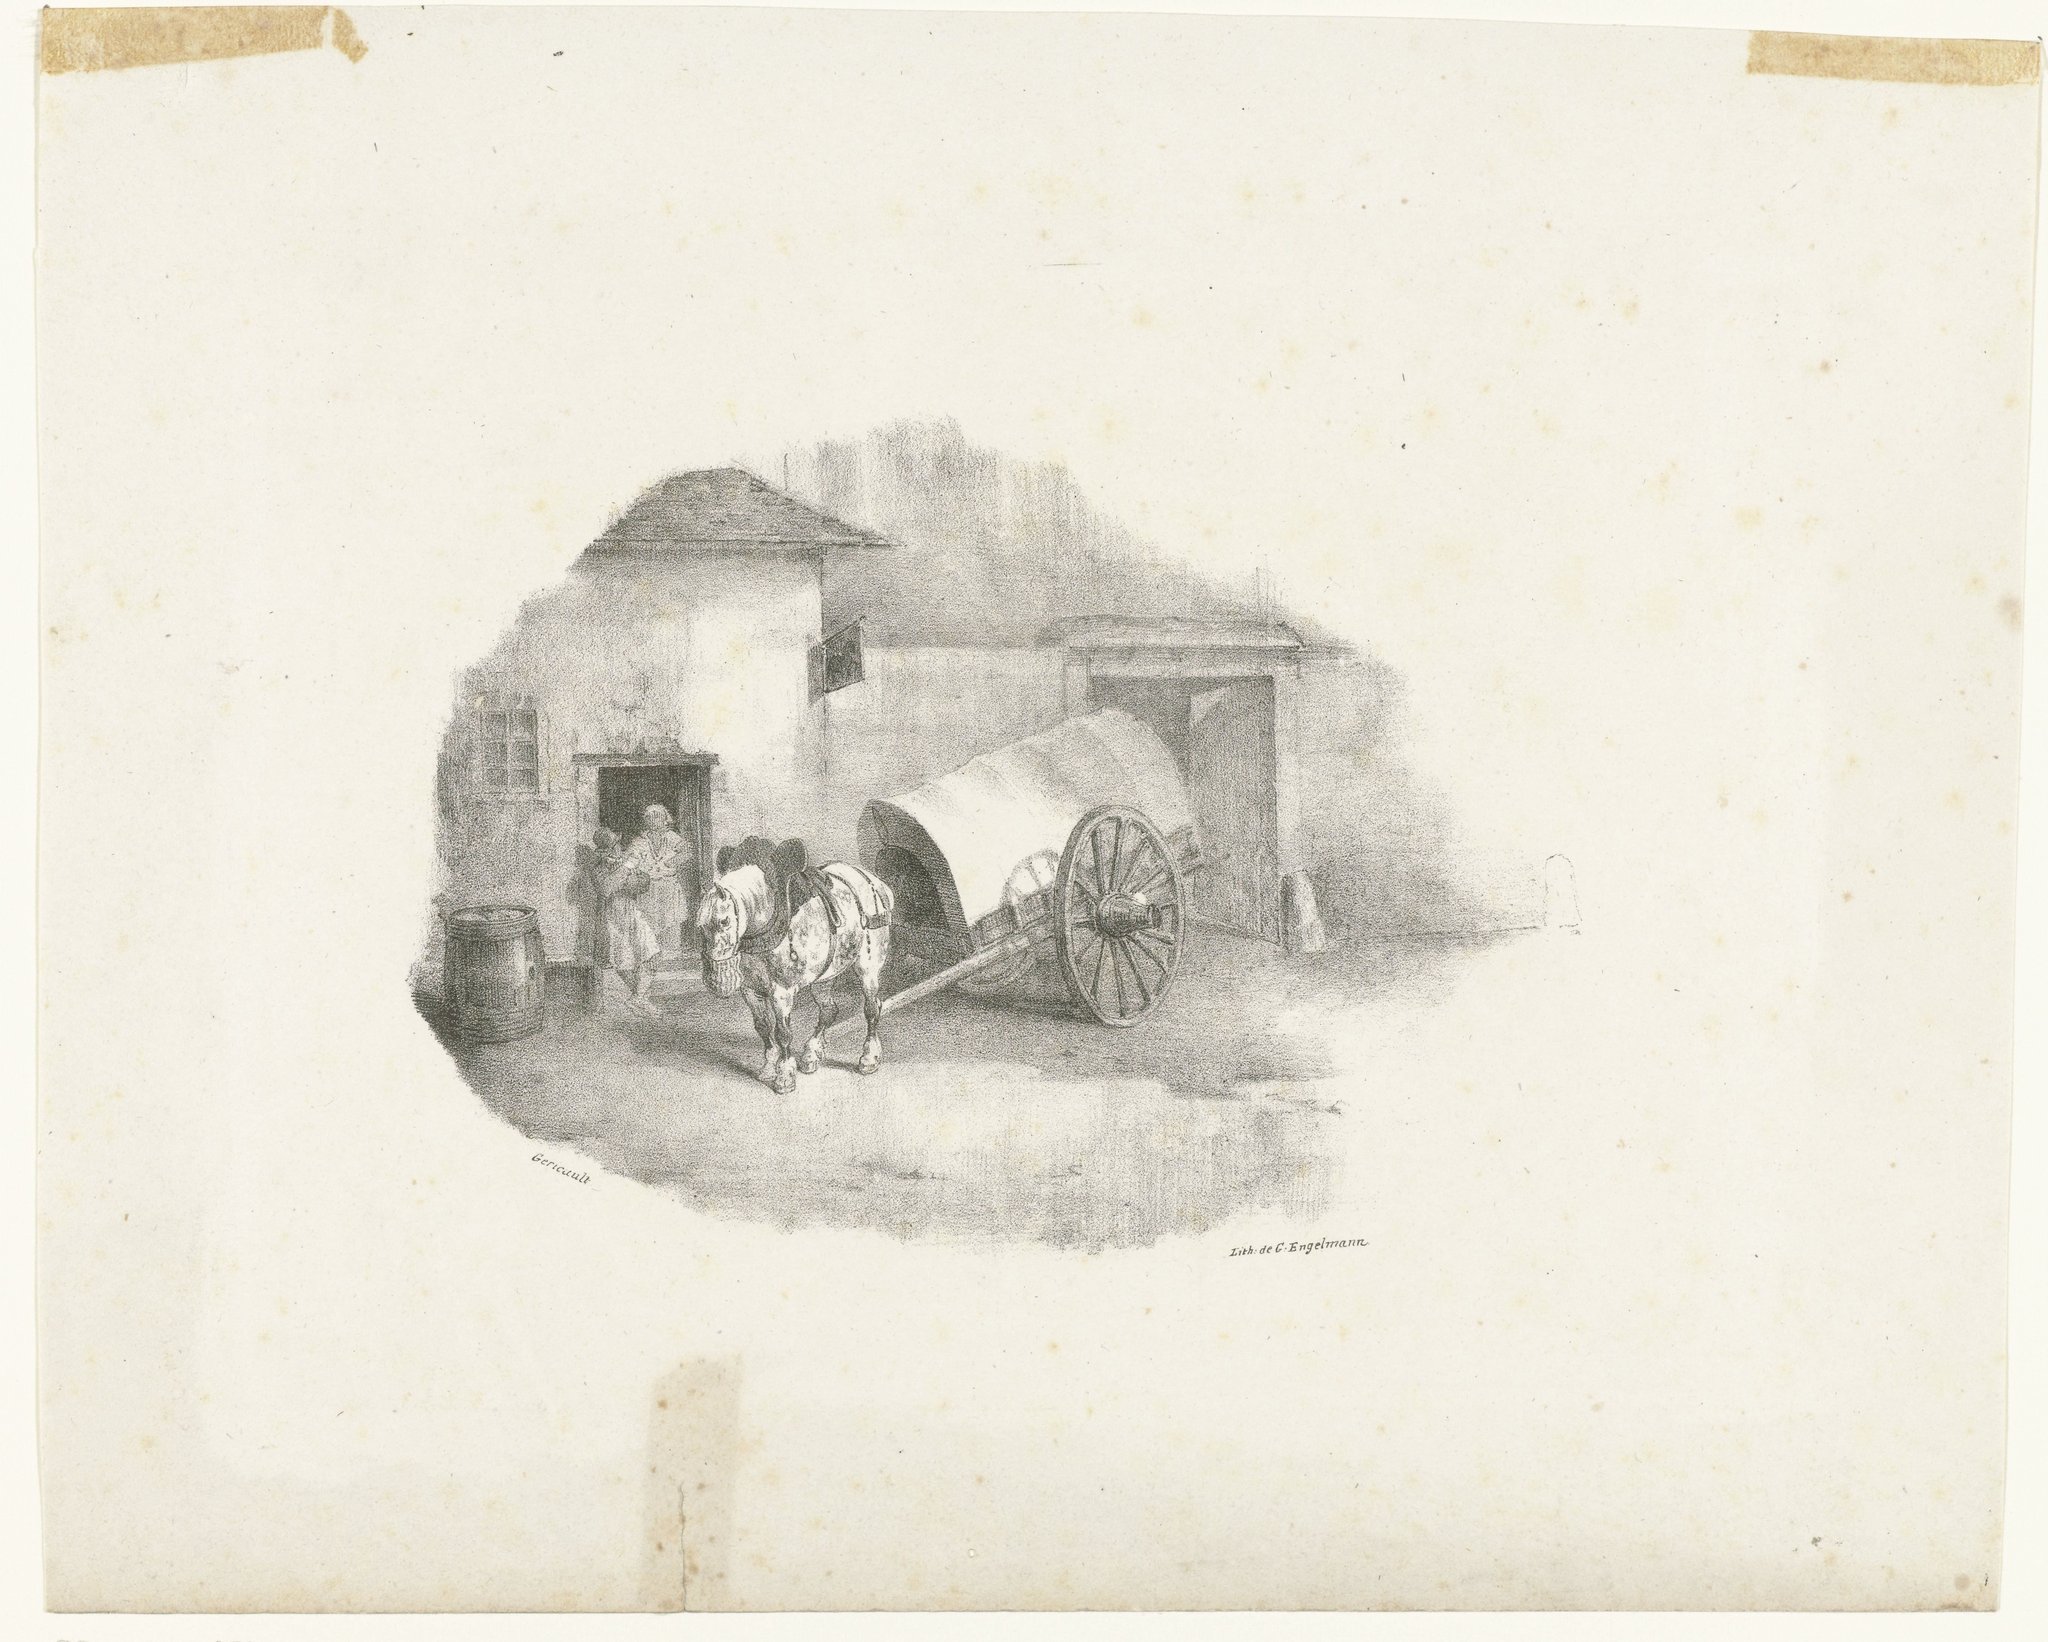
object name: print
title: Suite de Huit Petites Pièces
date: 1823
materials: paper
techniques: lithograph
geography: paris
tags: covered wagon, hooded wagon, horse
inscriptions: collector's mark: Lugt 789a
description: Een uitgespannen trekpaard eet zijn voer uit een zak die om zijn nek hangt. De huifkar staat achter hem. Een man en een vrouw staan bij de deuropening van een huis.